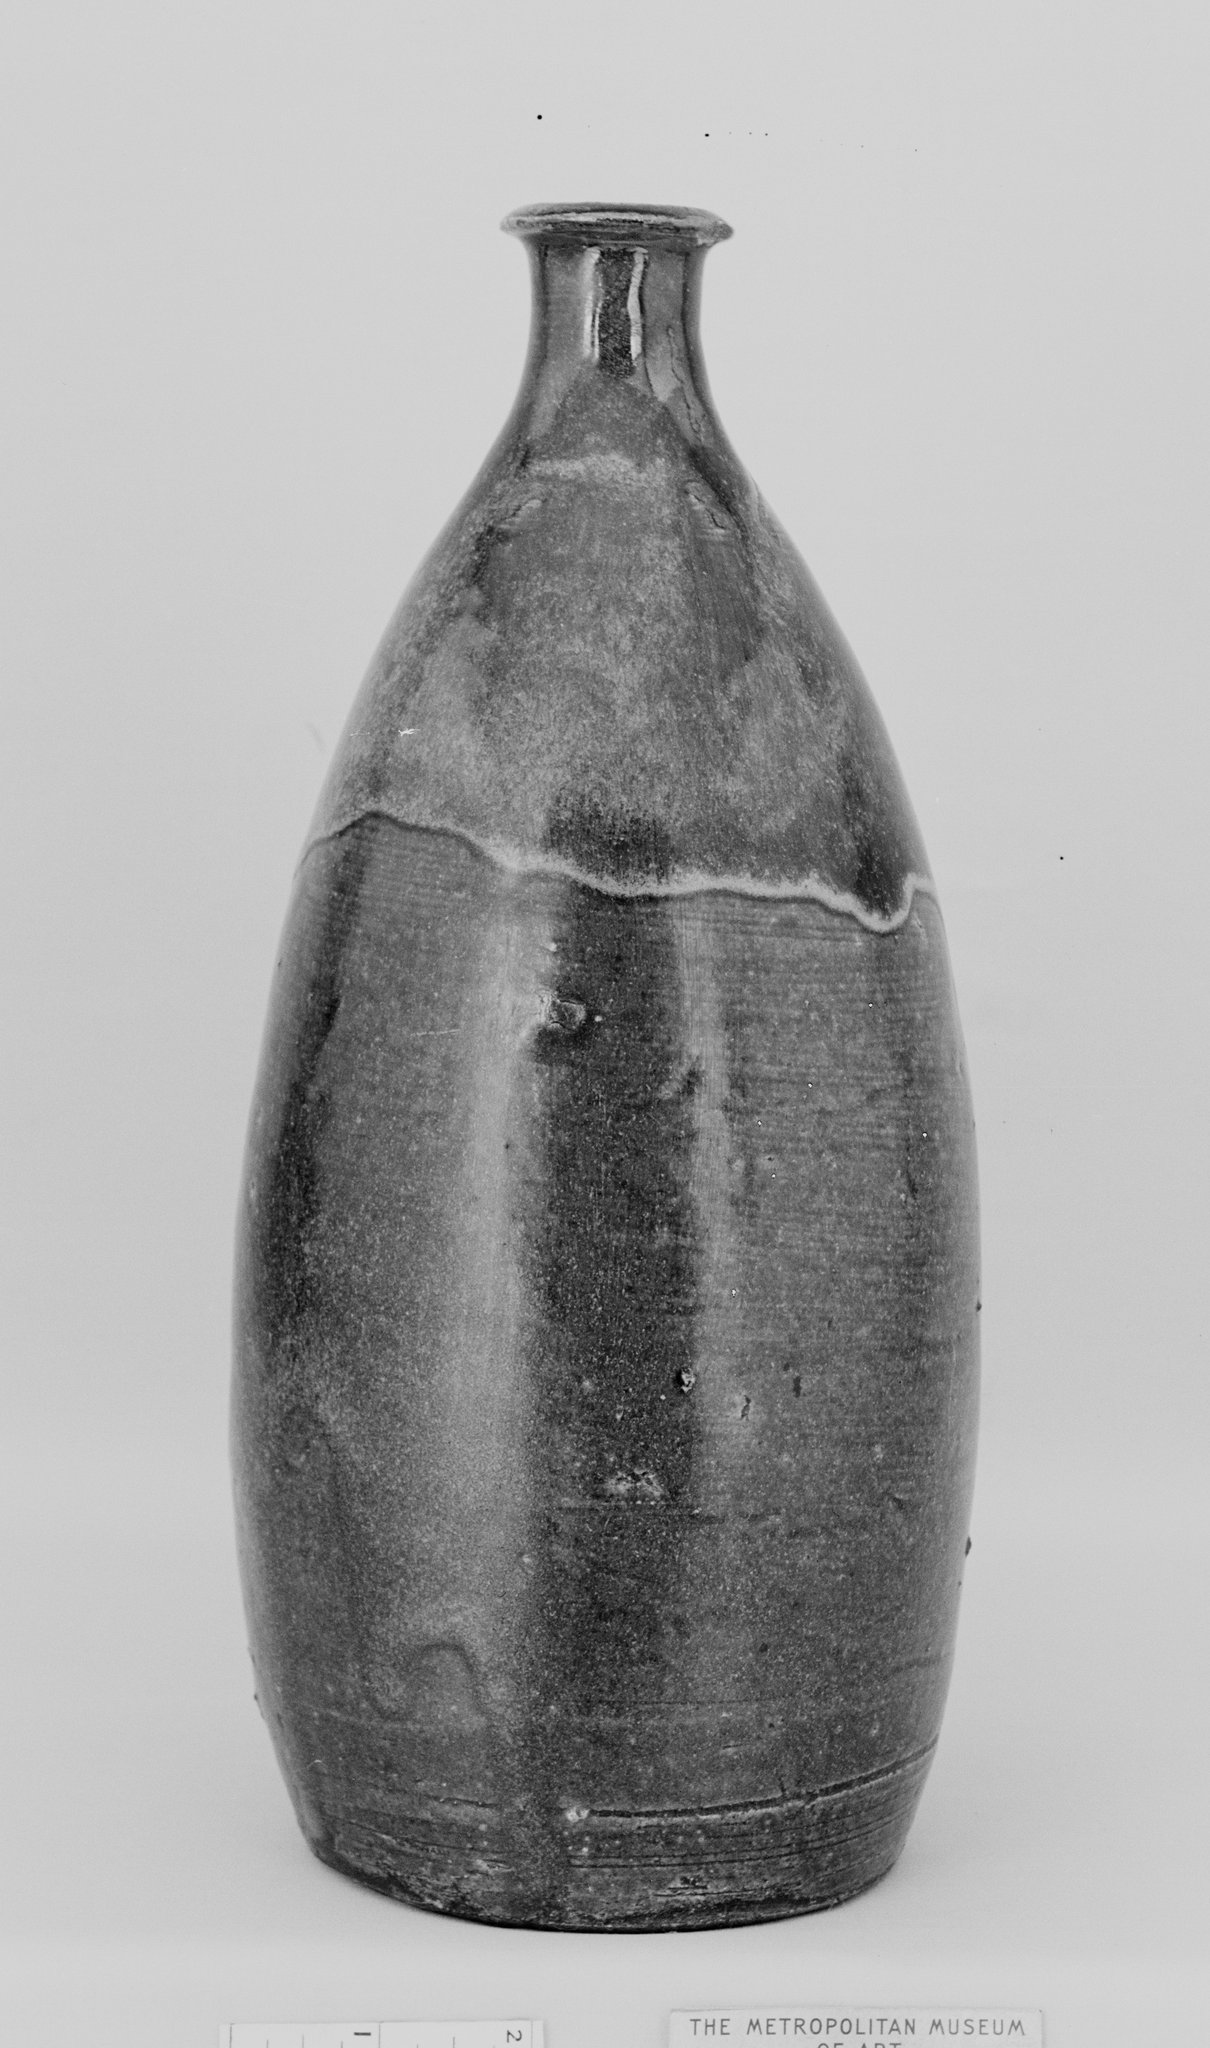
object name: bottle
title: Large Bottle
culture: japanese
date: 1701-1800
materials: clay, glaze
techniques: overglaze